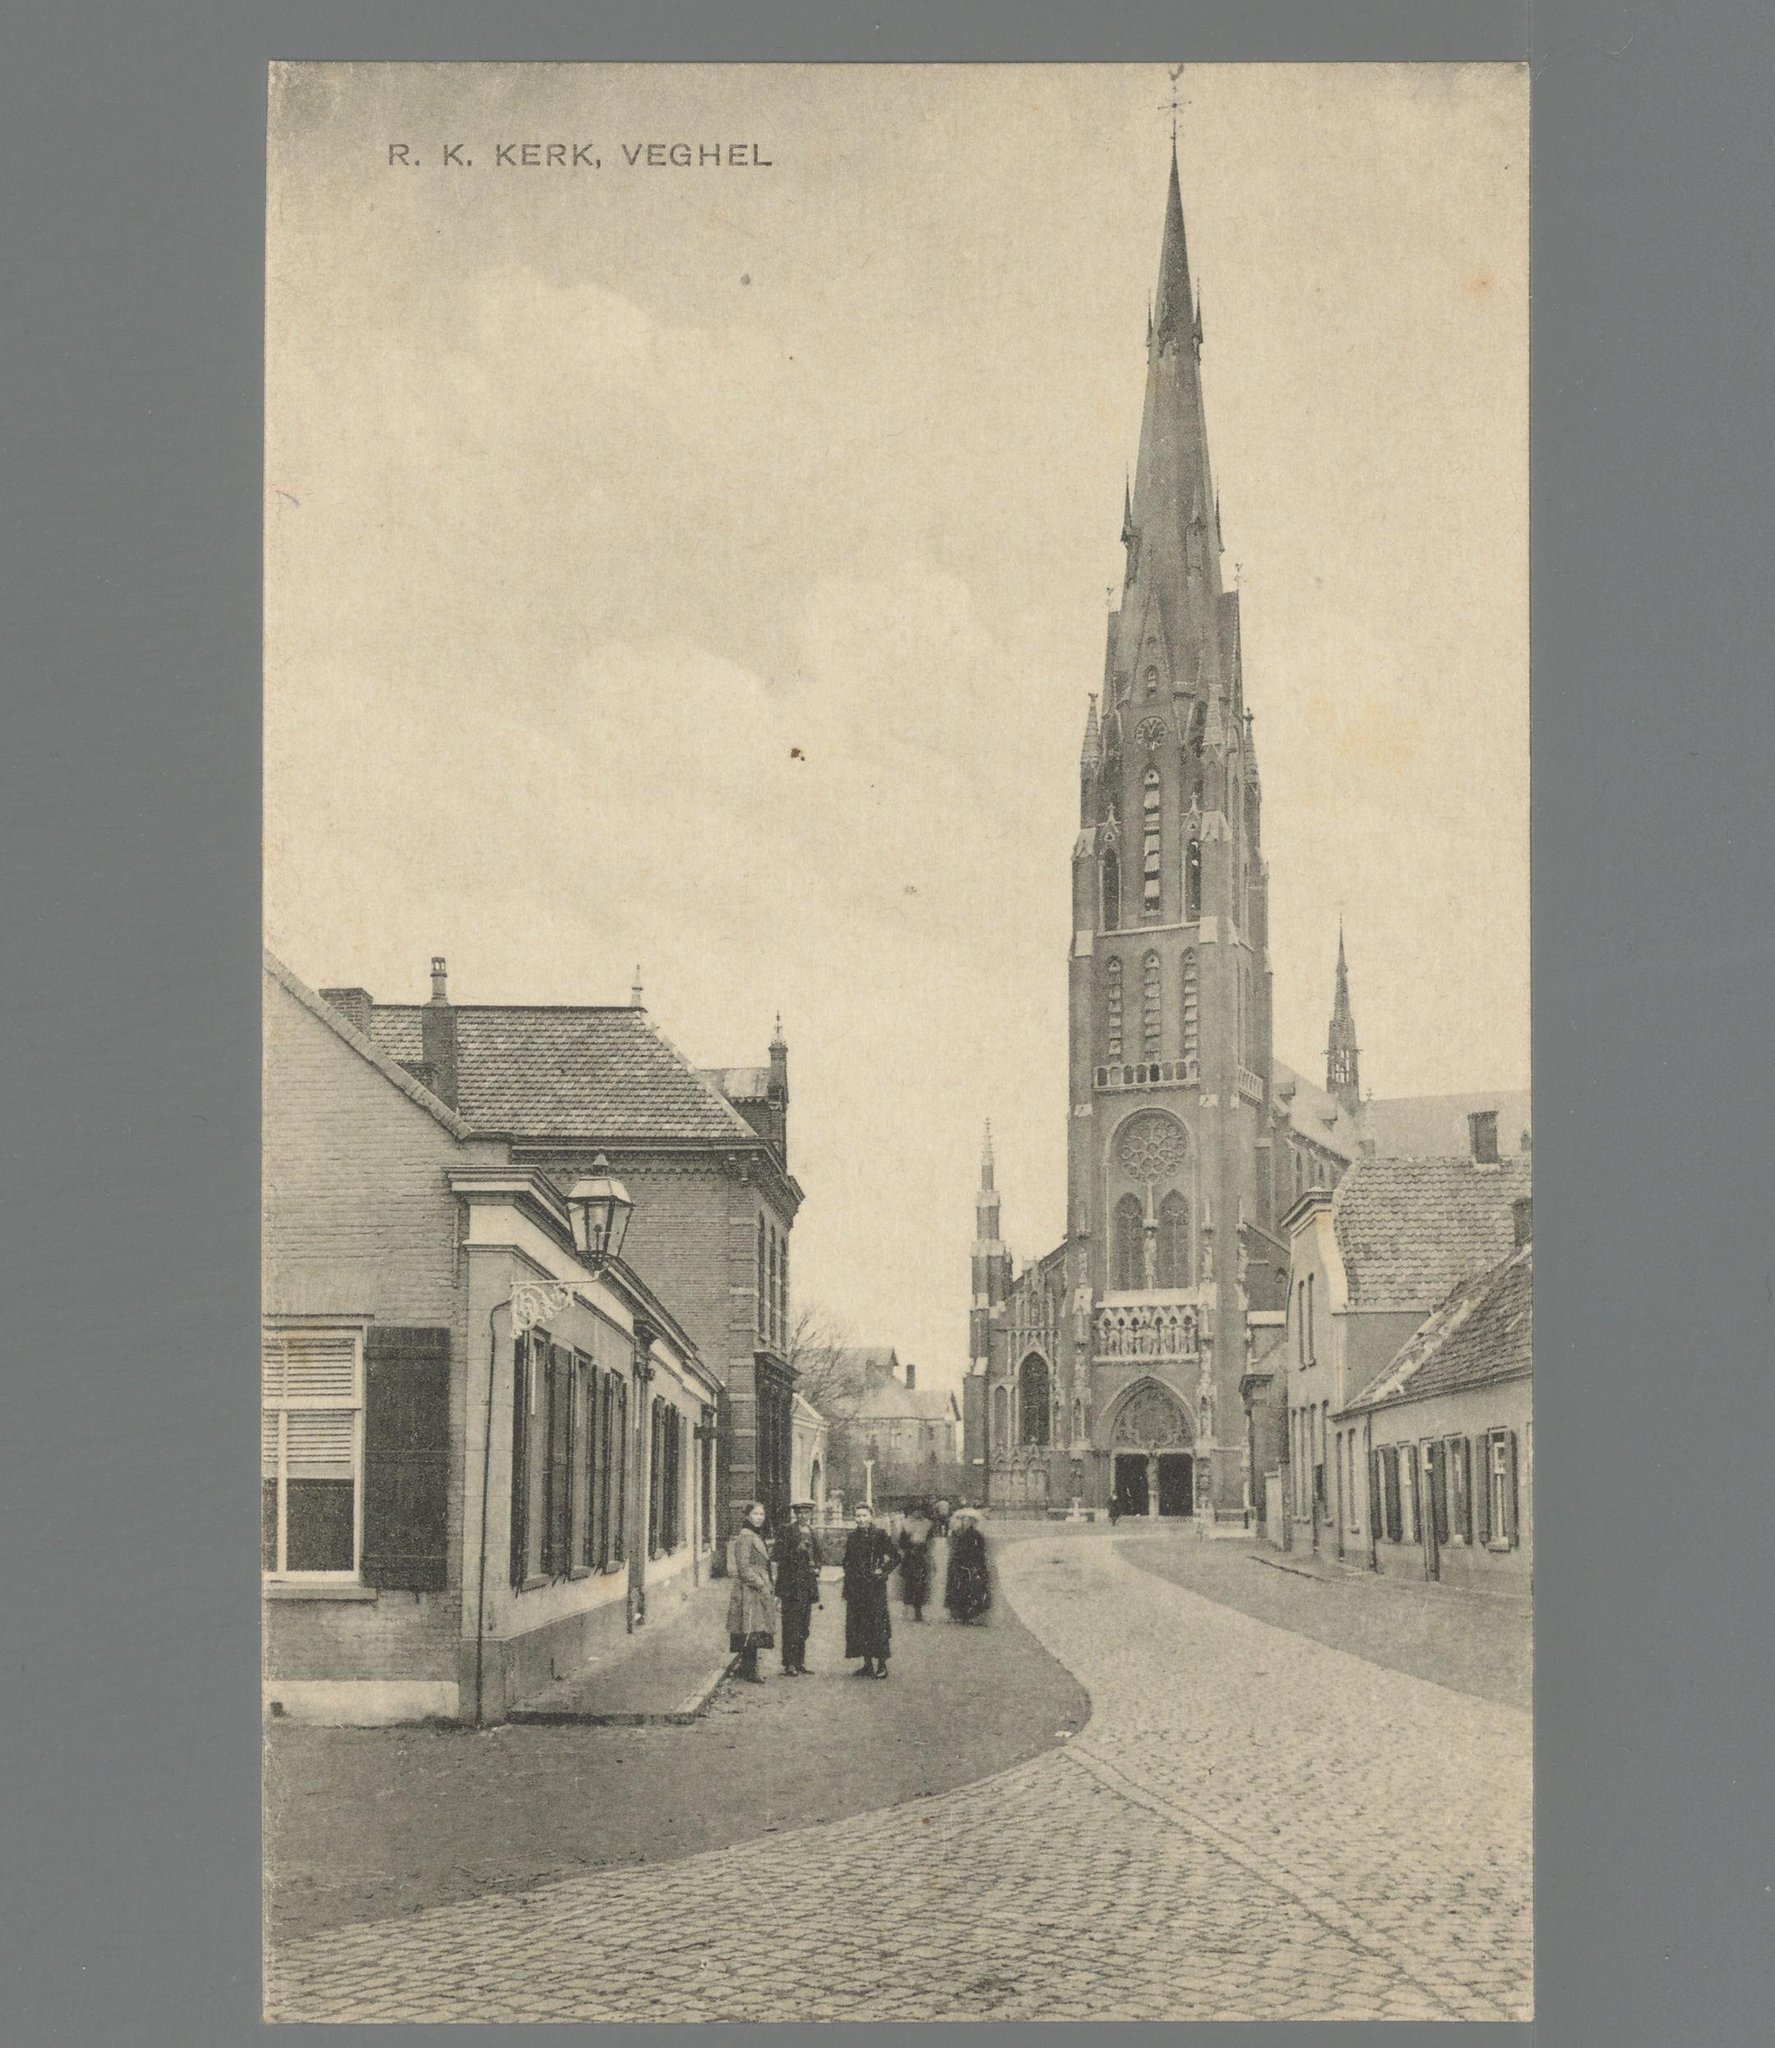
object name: photomechanical print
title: R. K. Kerk, Veghel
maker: Anonymous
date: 1905-1930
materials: cardboard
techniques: photograph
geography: veghel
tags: city-view, and landscape with man-made constructions, church (exterior)